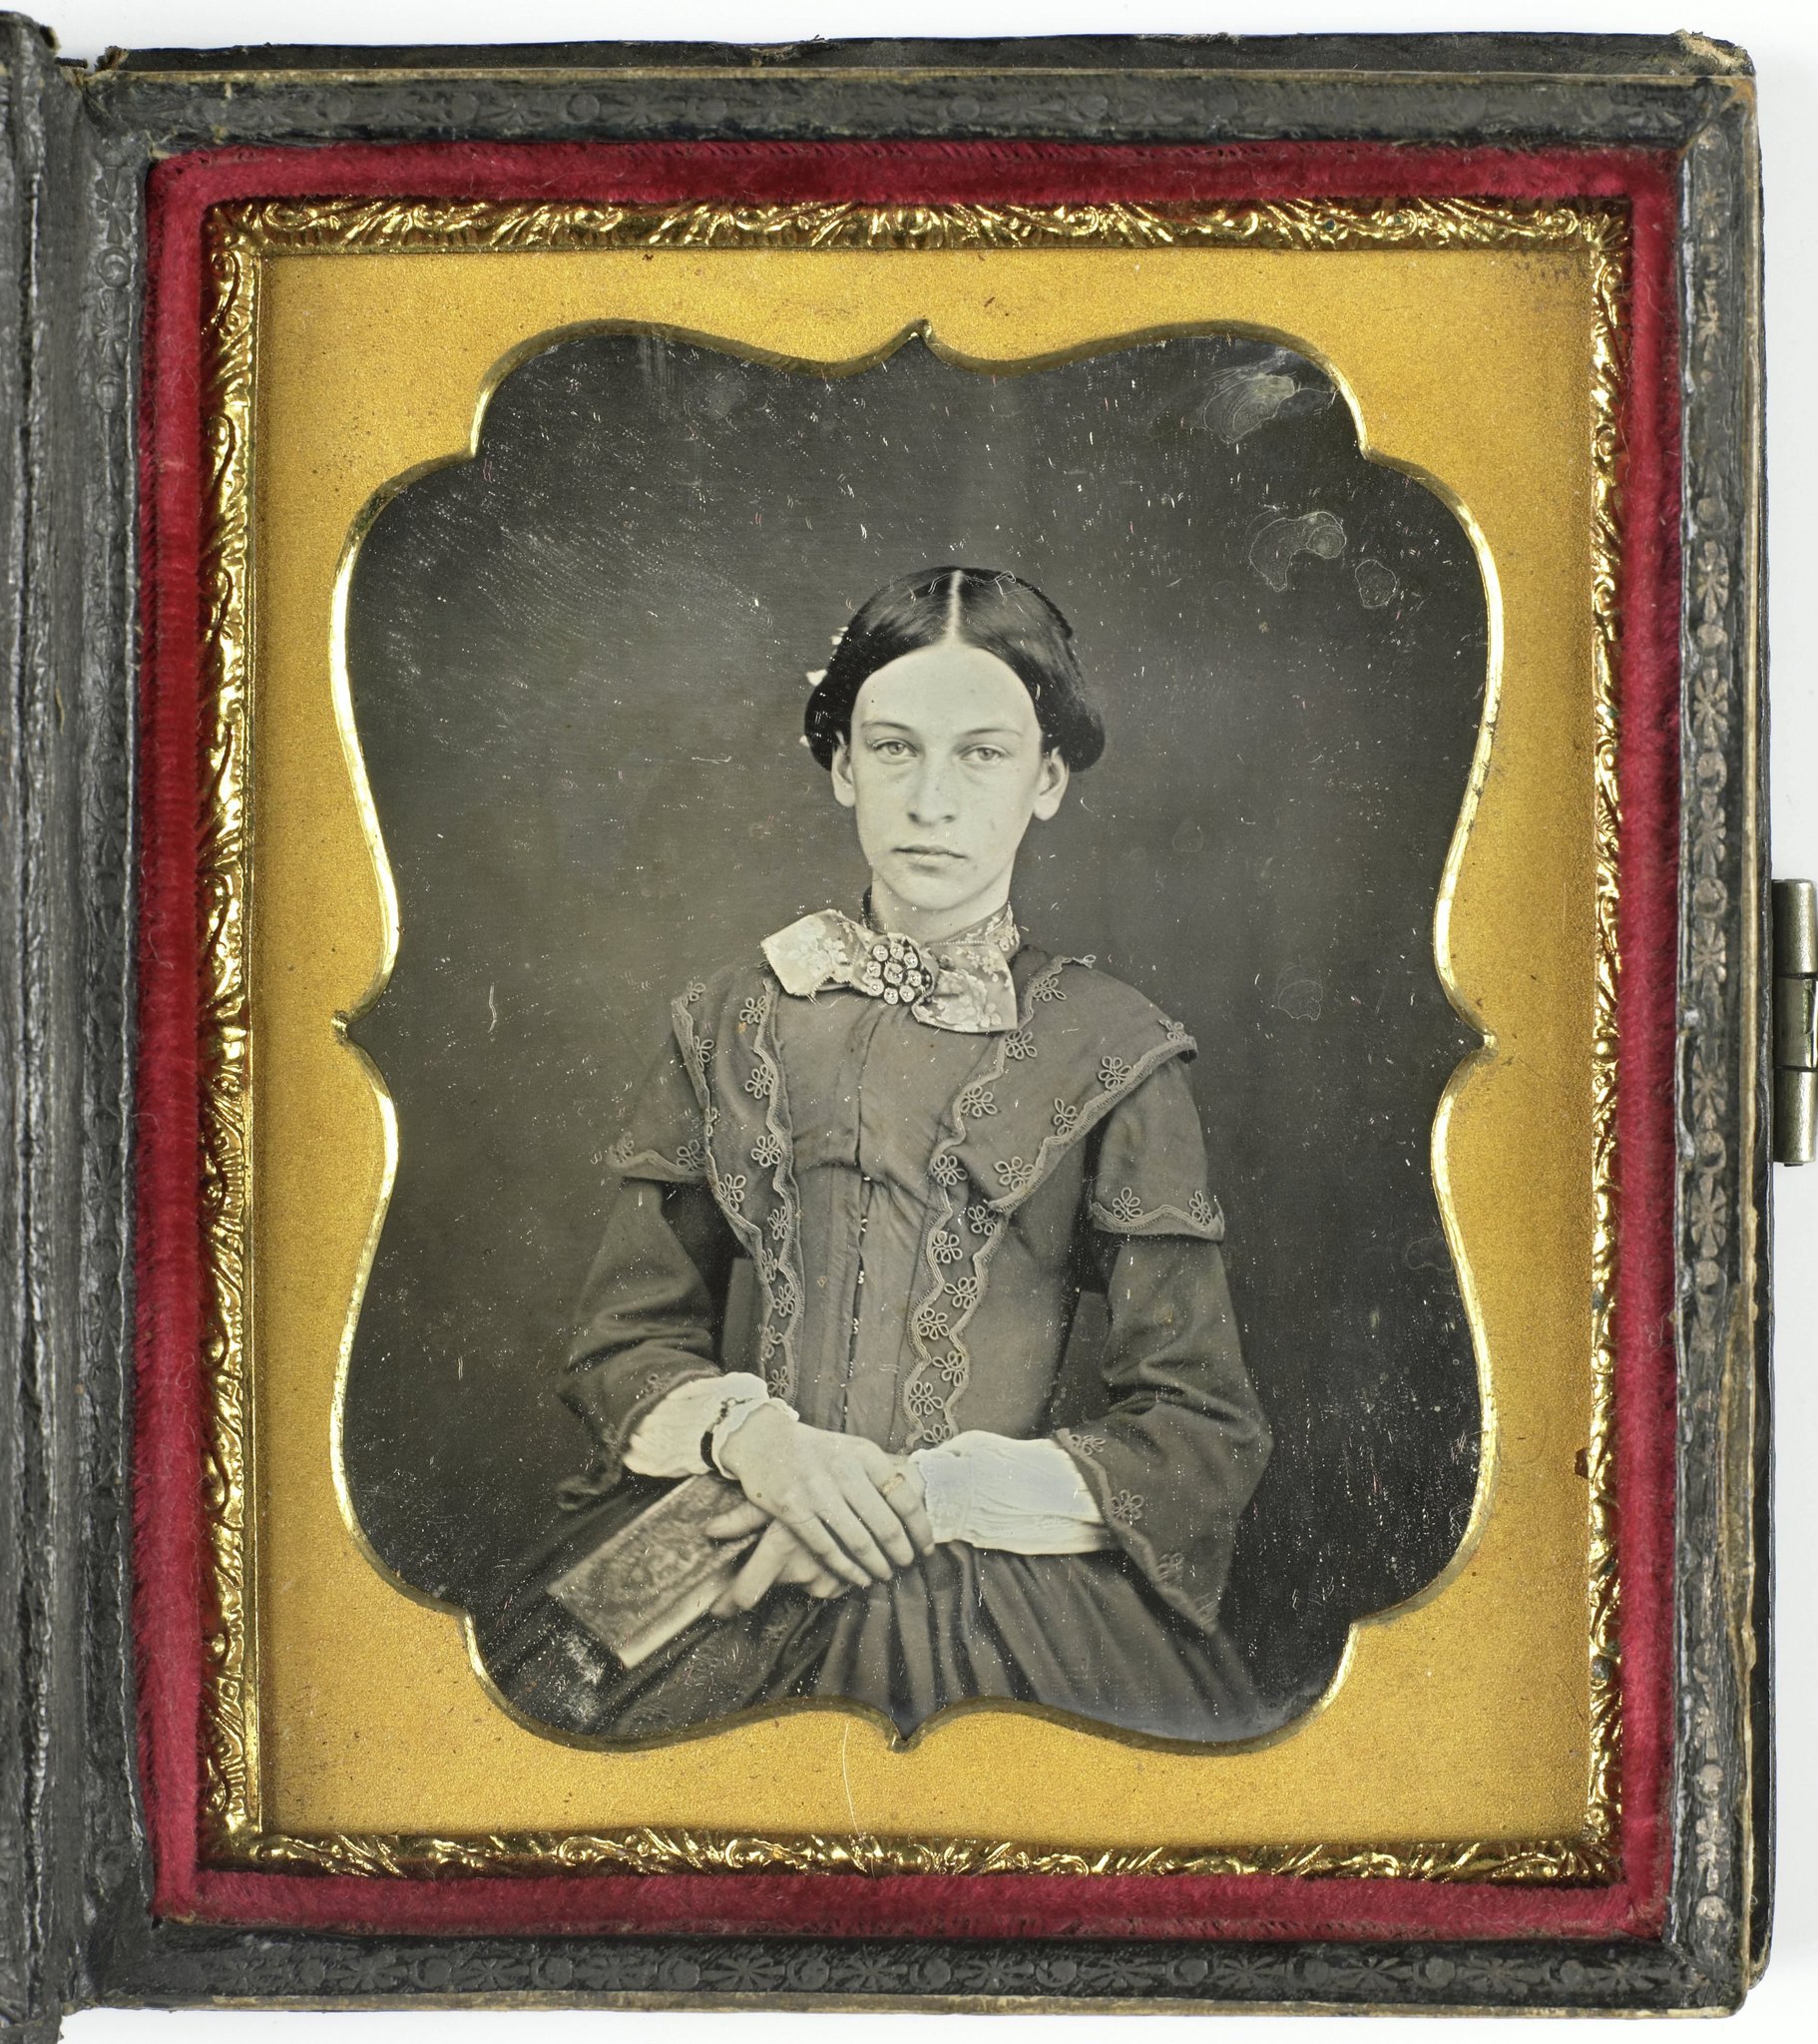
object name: photograph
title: Portret van een onbekende vrouw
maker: Anonymous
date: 1840-1860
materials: copper, glass, leather, mother of pearl, papier mâché, velvet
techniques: daguerreotype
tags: adult woman, historical persons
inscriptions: inscription: ‘Bijou’